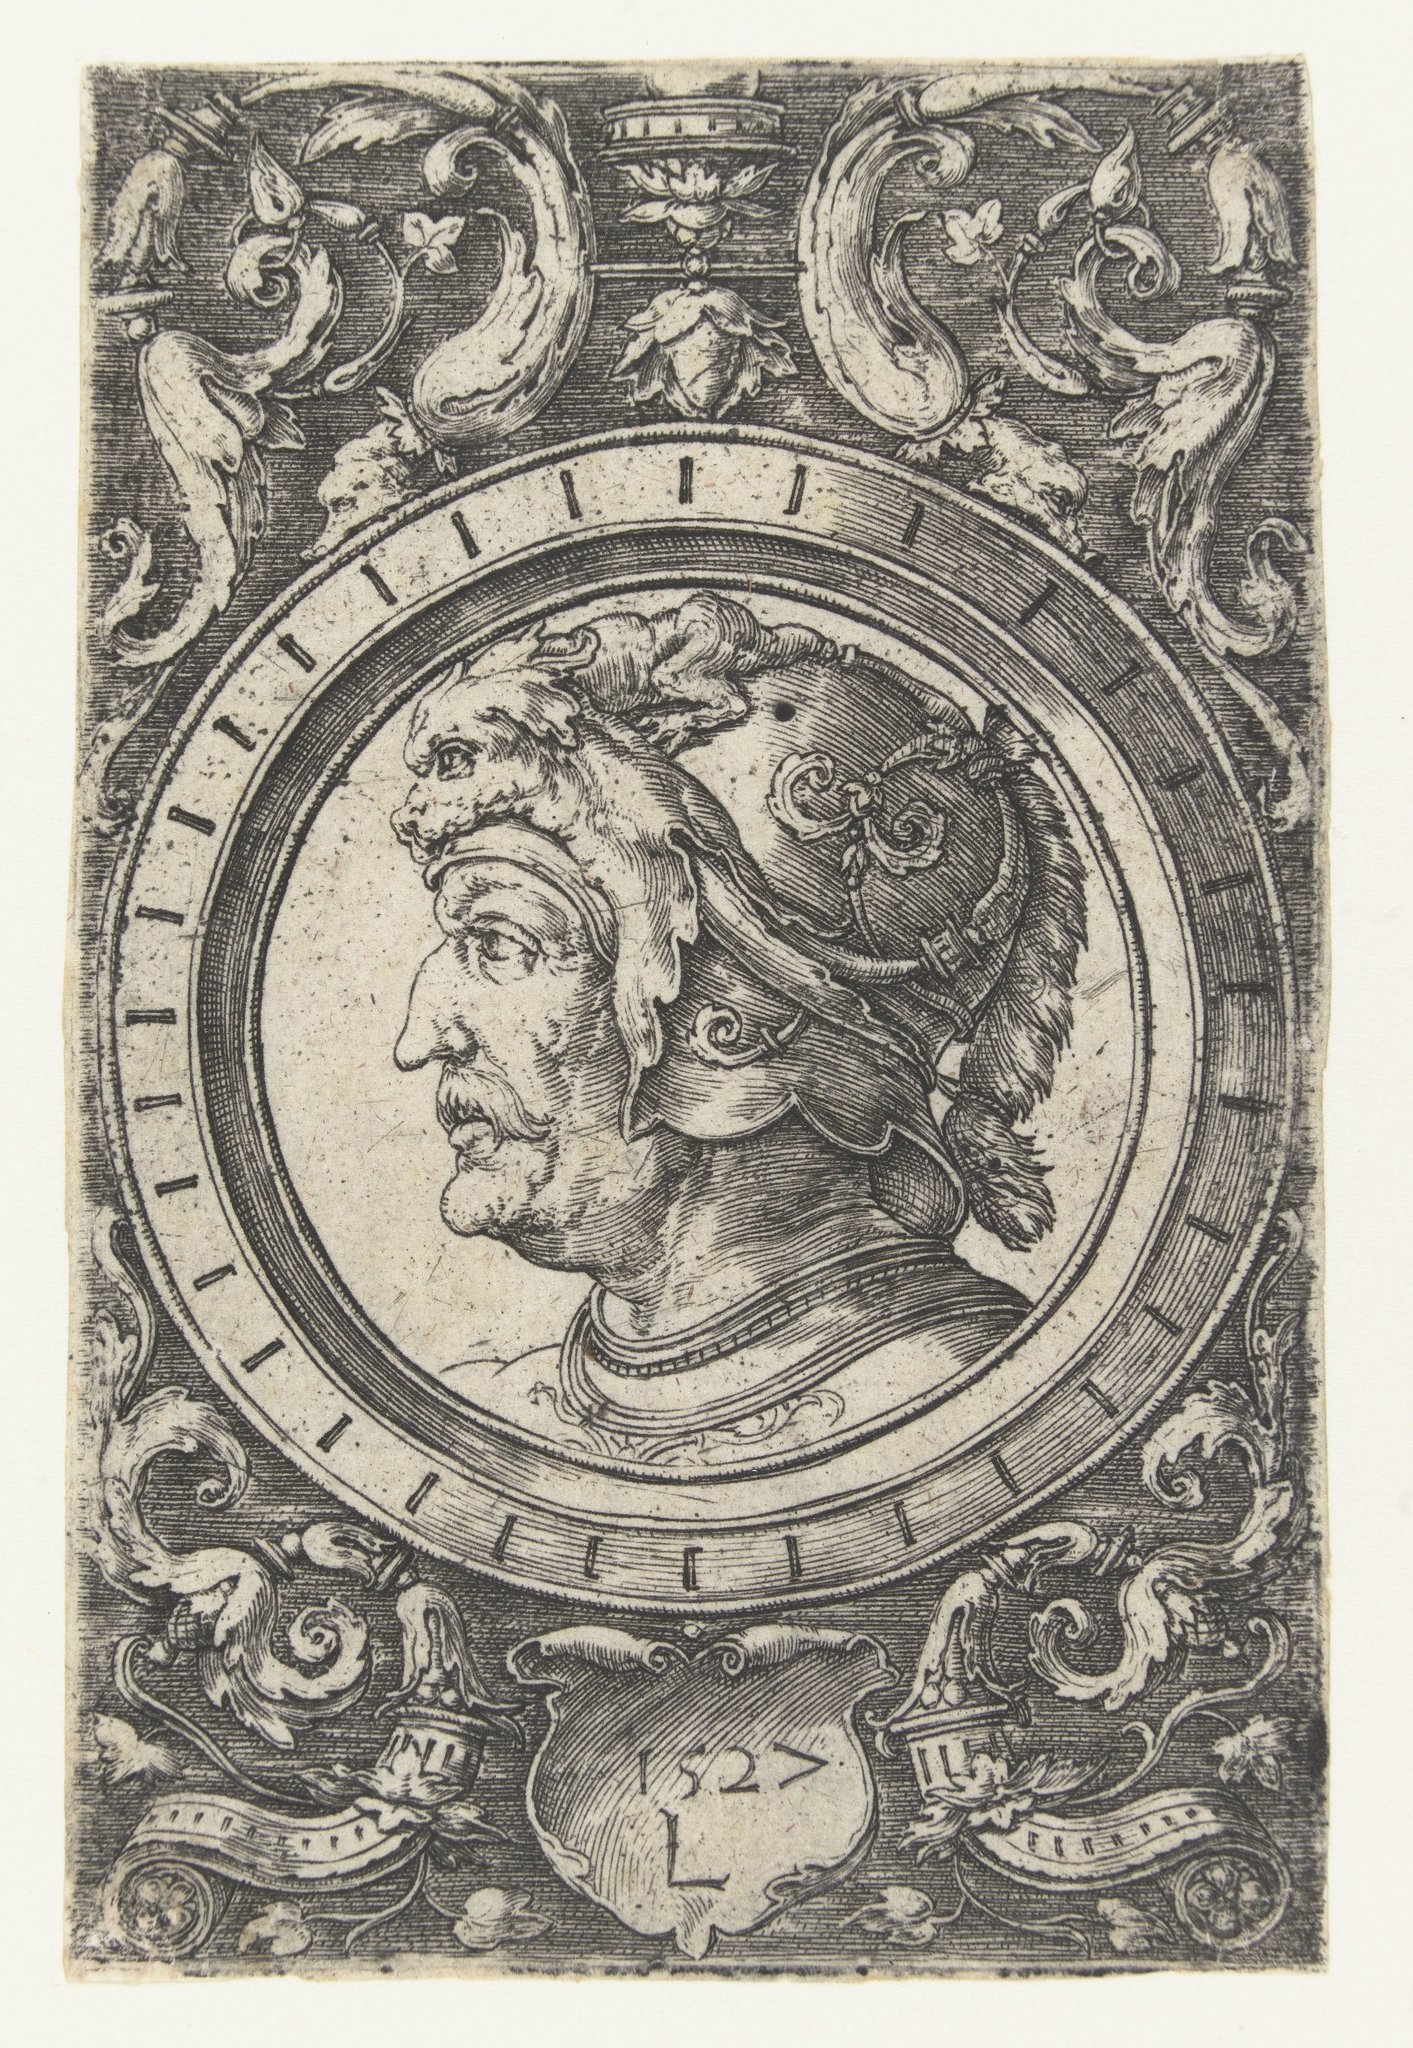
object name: ornament print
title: Ornament met kop van een soldaat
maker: lucas van leyden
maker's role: draughtsman, painter, print maker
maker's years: 1494-1533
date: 1527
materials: paper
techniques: engraving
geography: low countries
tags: head (human), ornament derived from plant forms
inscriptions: collector's mark: Lugt 2228a